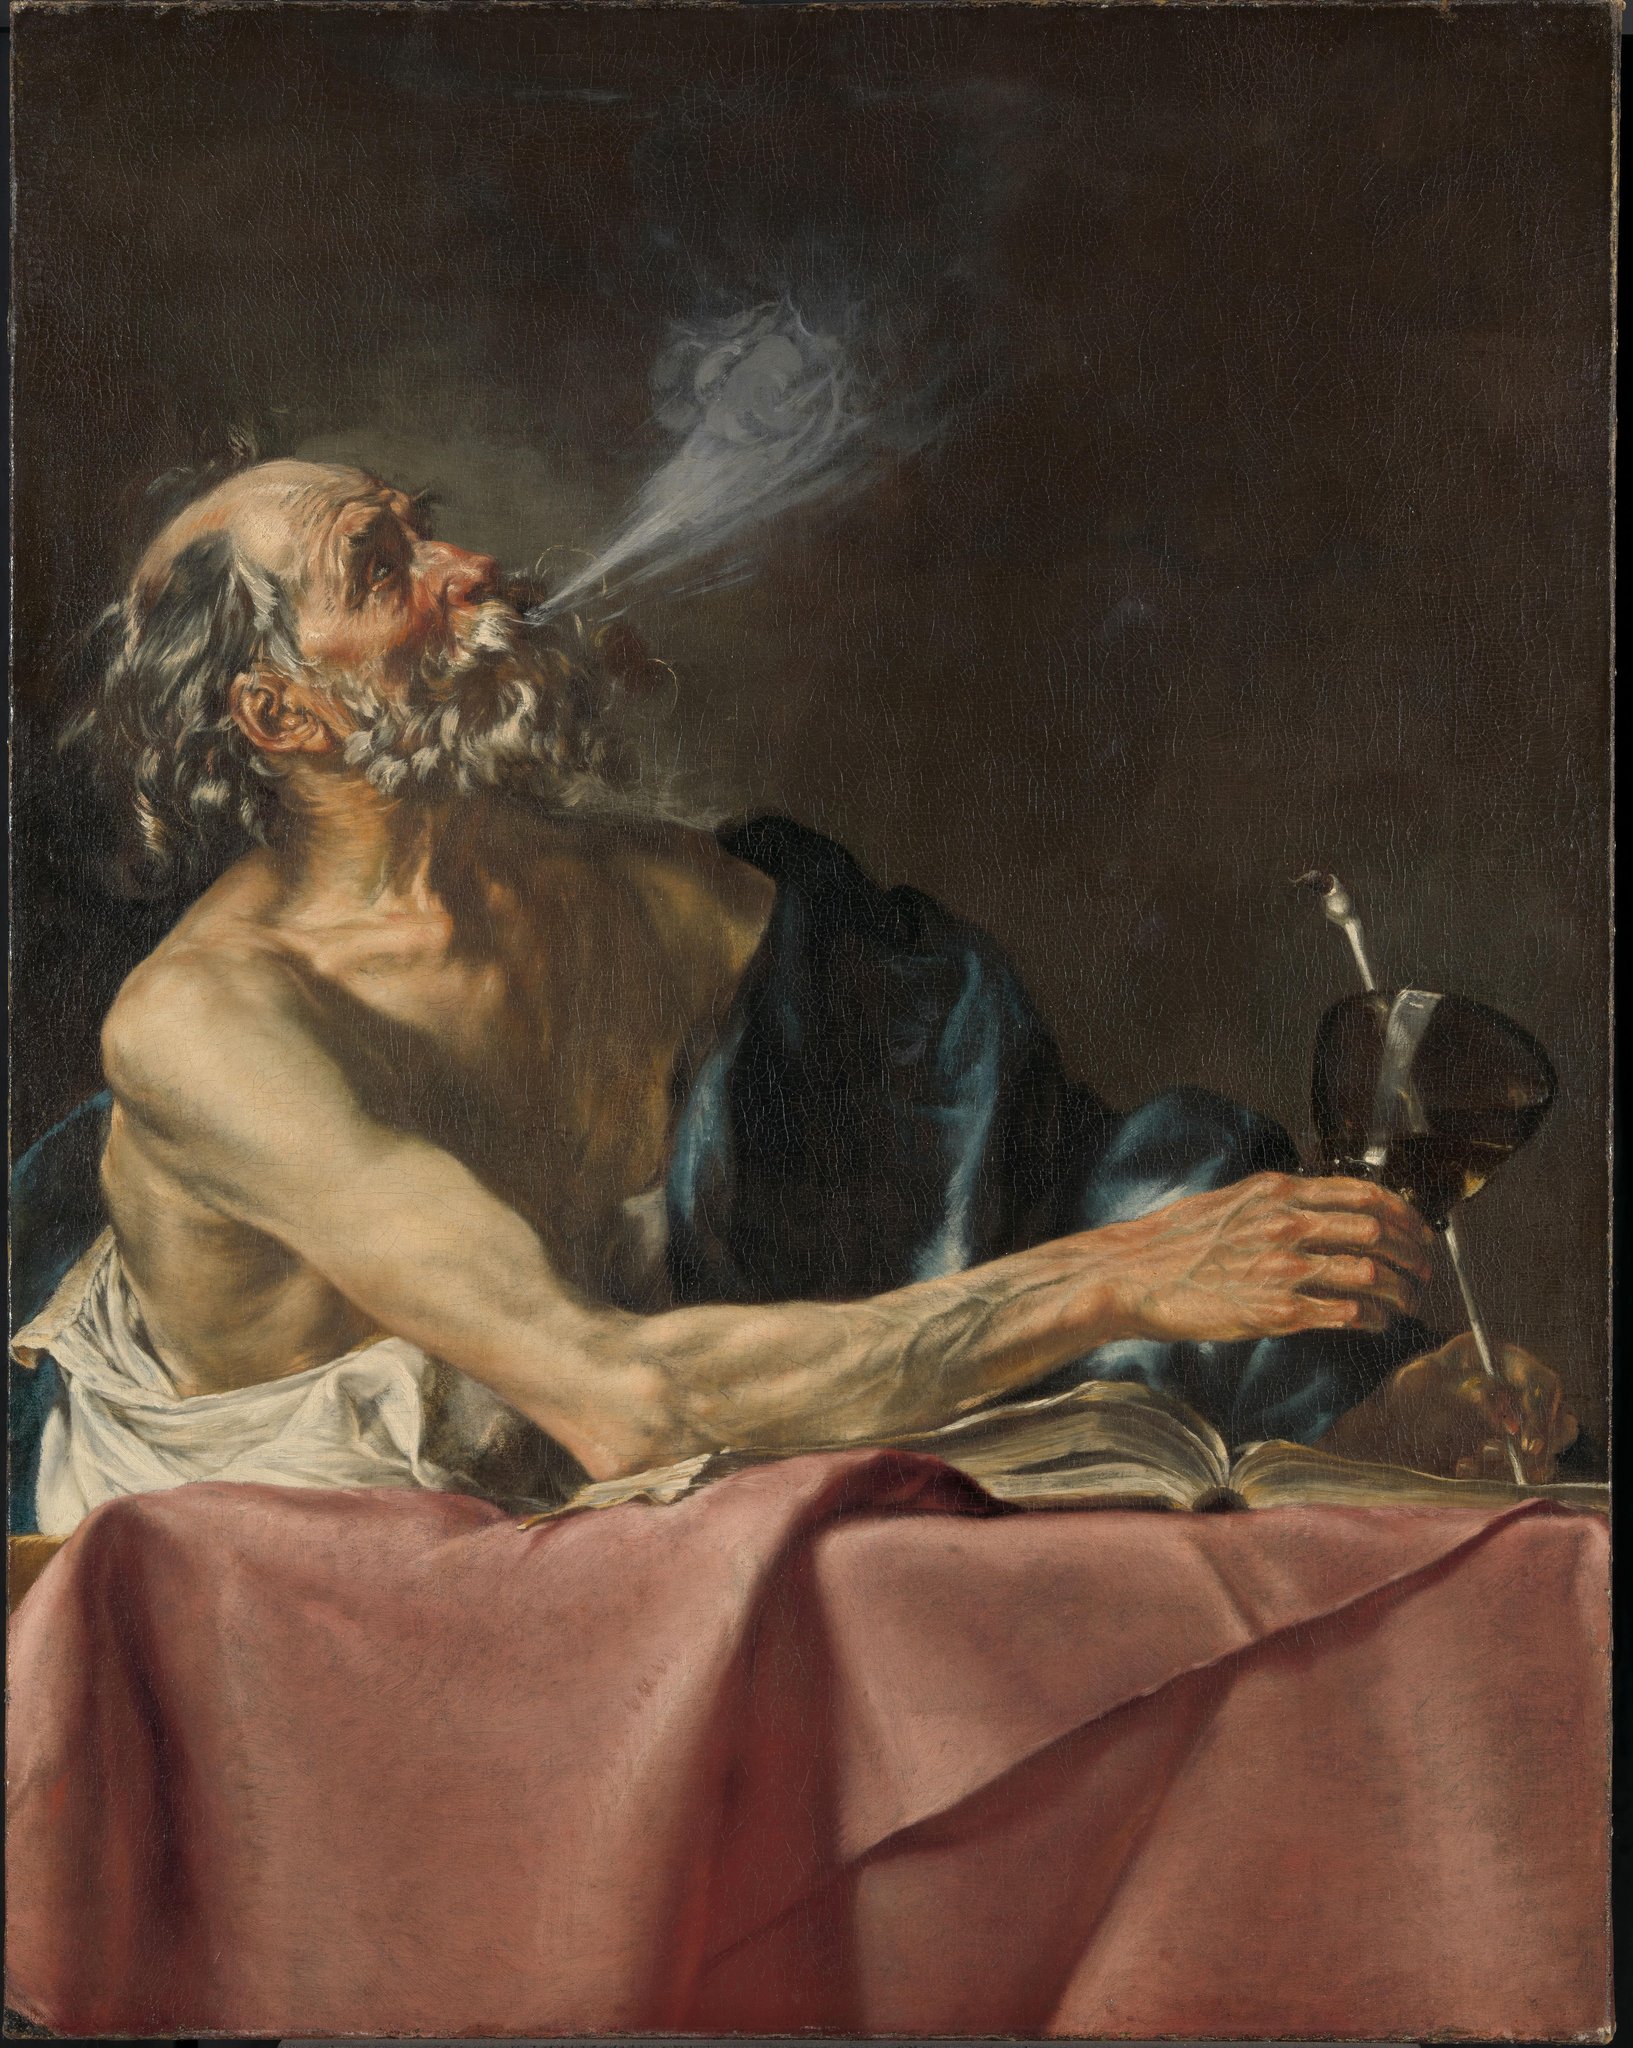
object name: painting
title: The Smoker Allegory of Transience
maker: hendrick van someren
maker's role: draughtsman, painter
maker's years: 1615-1685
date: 1615-1625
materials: canvas, oil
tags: scenes symbolizing 'vanitas', pipe ~ tobacco, old man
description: De roker; allegorie op de vergankelijkheid. Een oude man die aan een tafel gezeten een pijp rookt, in de rechterhand een roemer, in de linkerhand een pijp. Op tafel ligt een opengeslagen boek.